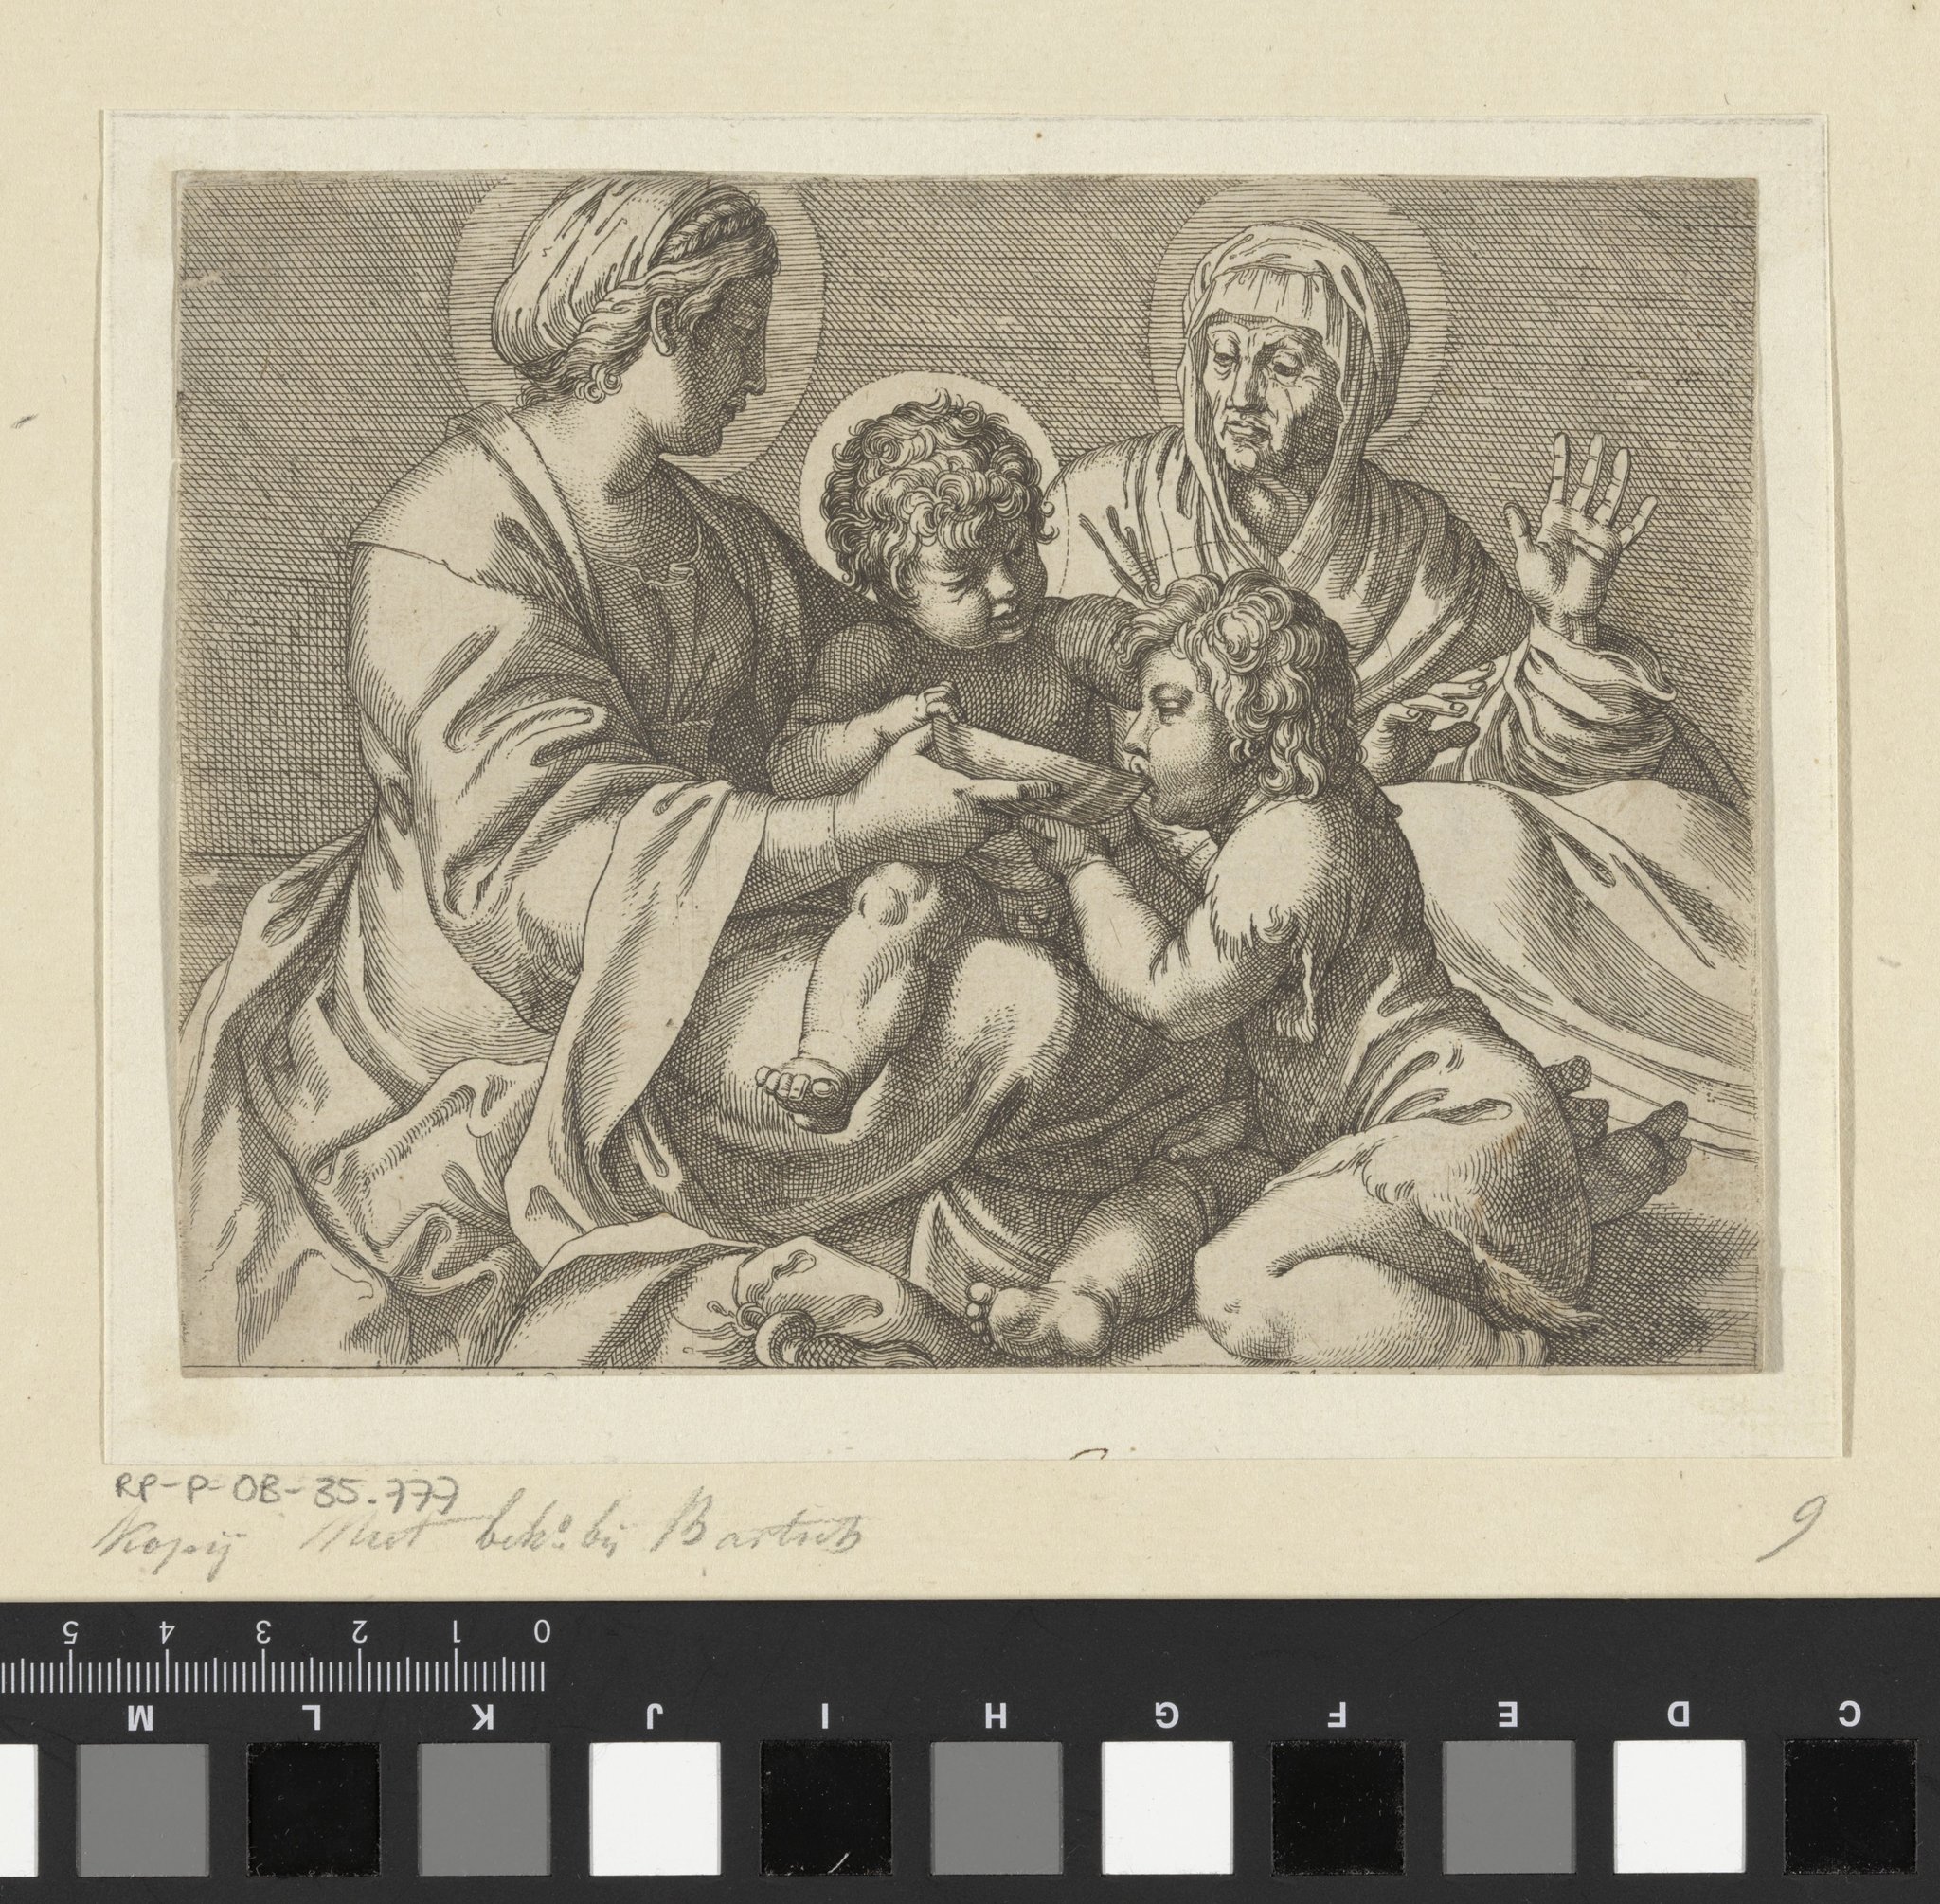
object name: print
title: Maria met het Christuskind, de jonge Johannes de Doper en Elisabet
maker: Anonymous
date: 1606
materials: paper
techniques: engraving, etching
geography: italy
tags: mary, the christ-child and john the baptist, elisabeth present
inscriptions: collector's mark: Lugt 240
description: Maria zit met het Christuskind op schoot. De jonge Johannes de Doper drinkt uit een schoteltje dat Maria en Christus samen vasthouden. Op de achtergrond staat Elisabet.